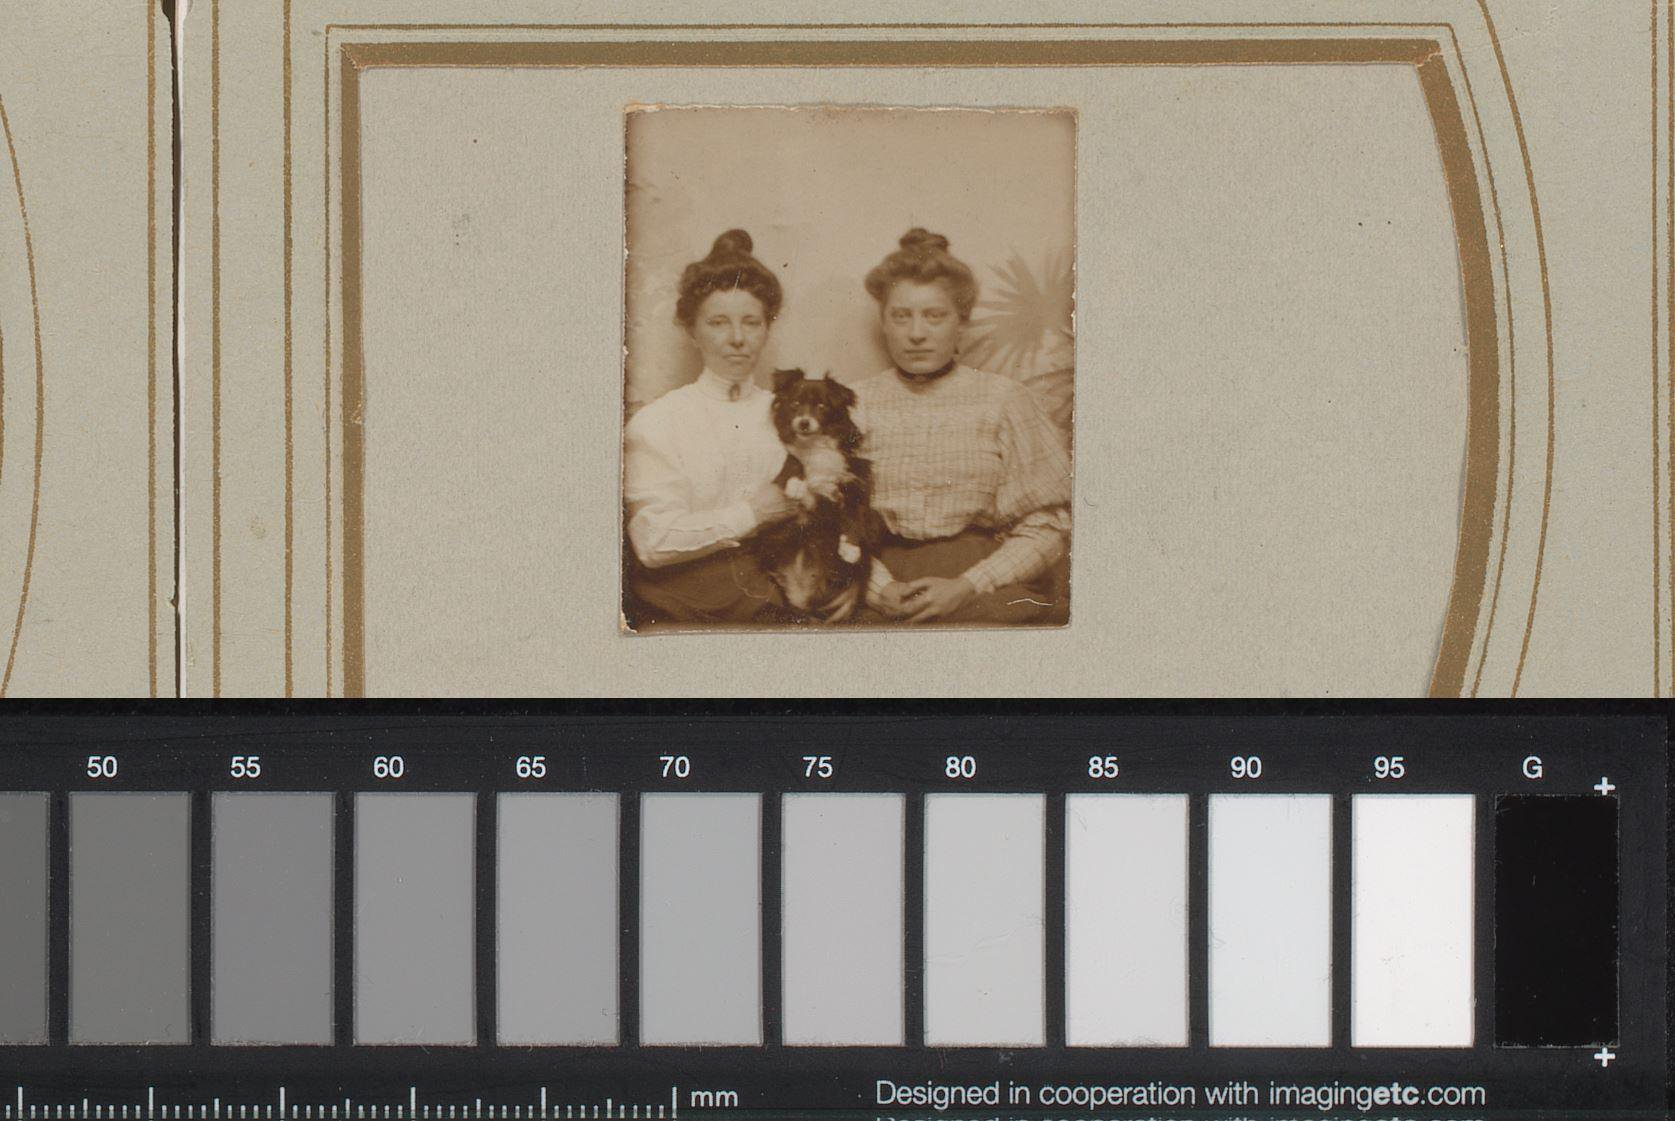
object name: carte de visite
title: Portret van twee jonge vrouwen en een hond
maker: Anonymous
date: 1880-1920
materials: cardboard, photographic support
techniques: collodion silver print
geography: netherlands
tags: historical persons - bb - woman, adolescent, young woman, maiden (+ two persons), dog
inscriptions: annotation: ‘Li[.]e Mul[d]er/ hondje/ dienstmeisje’